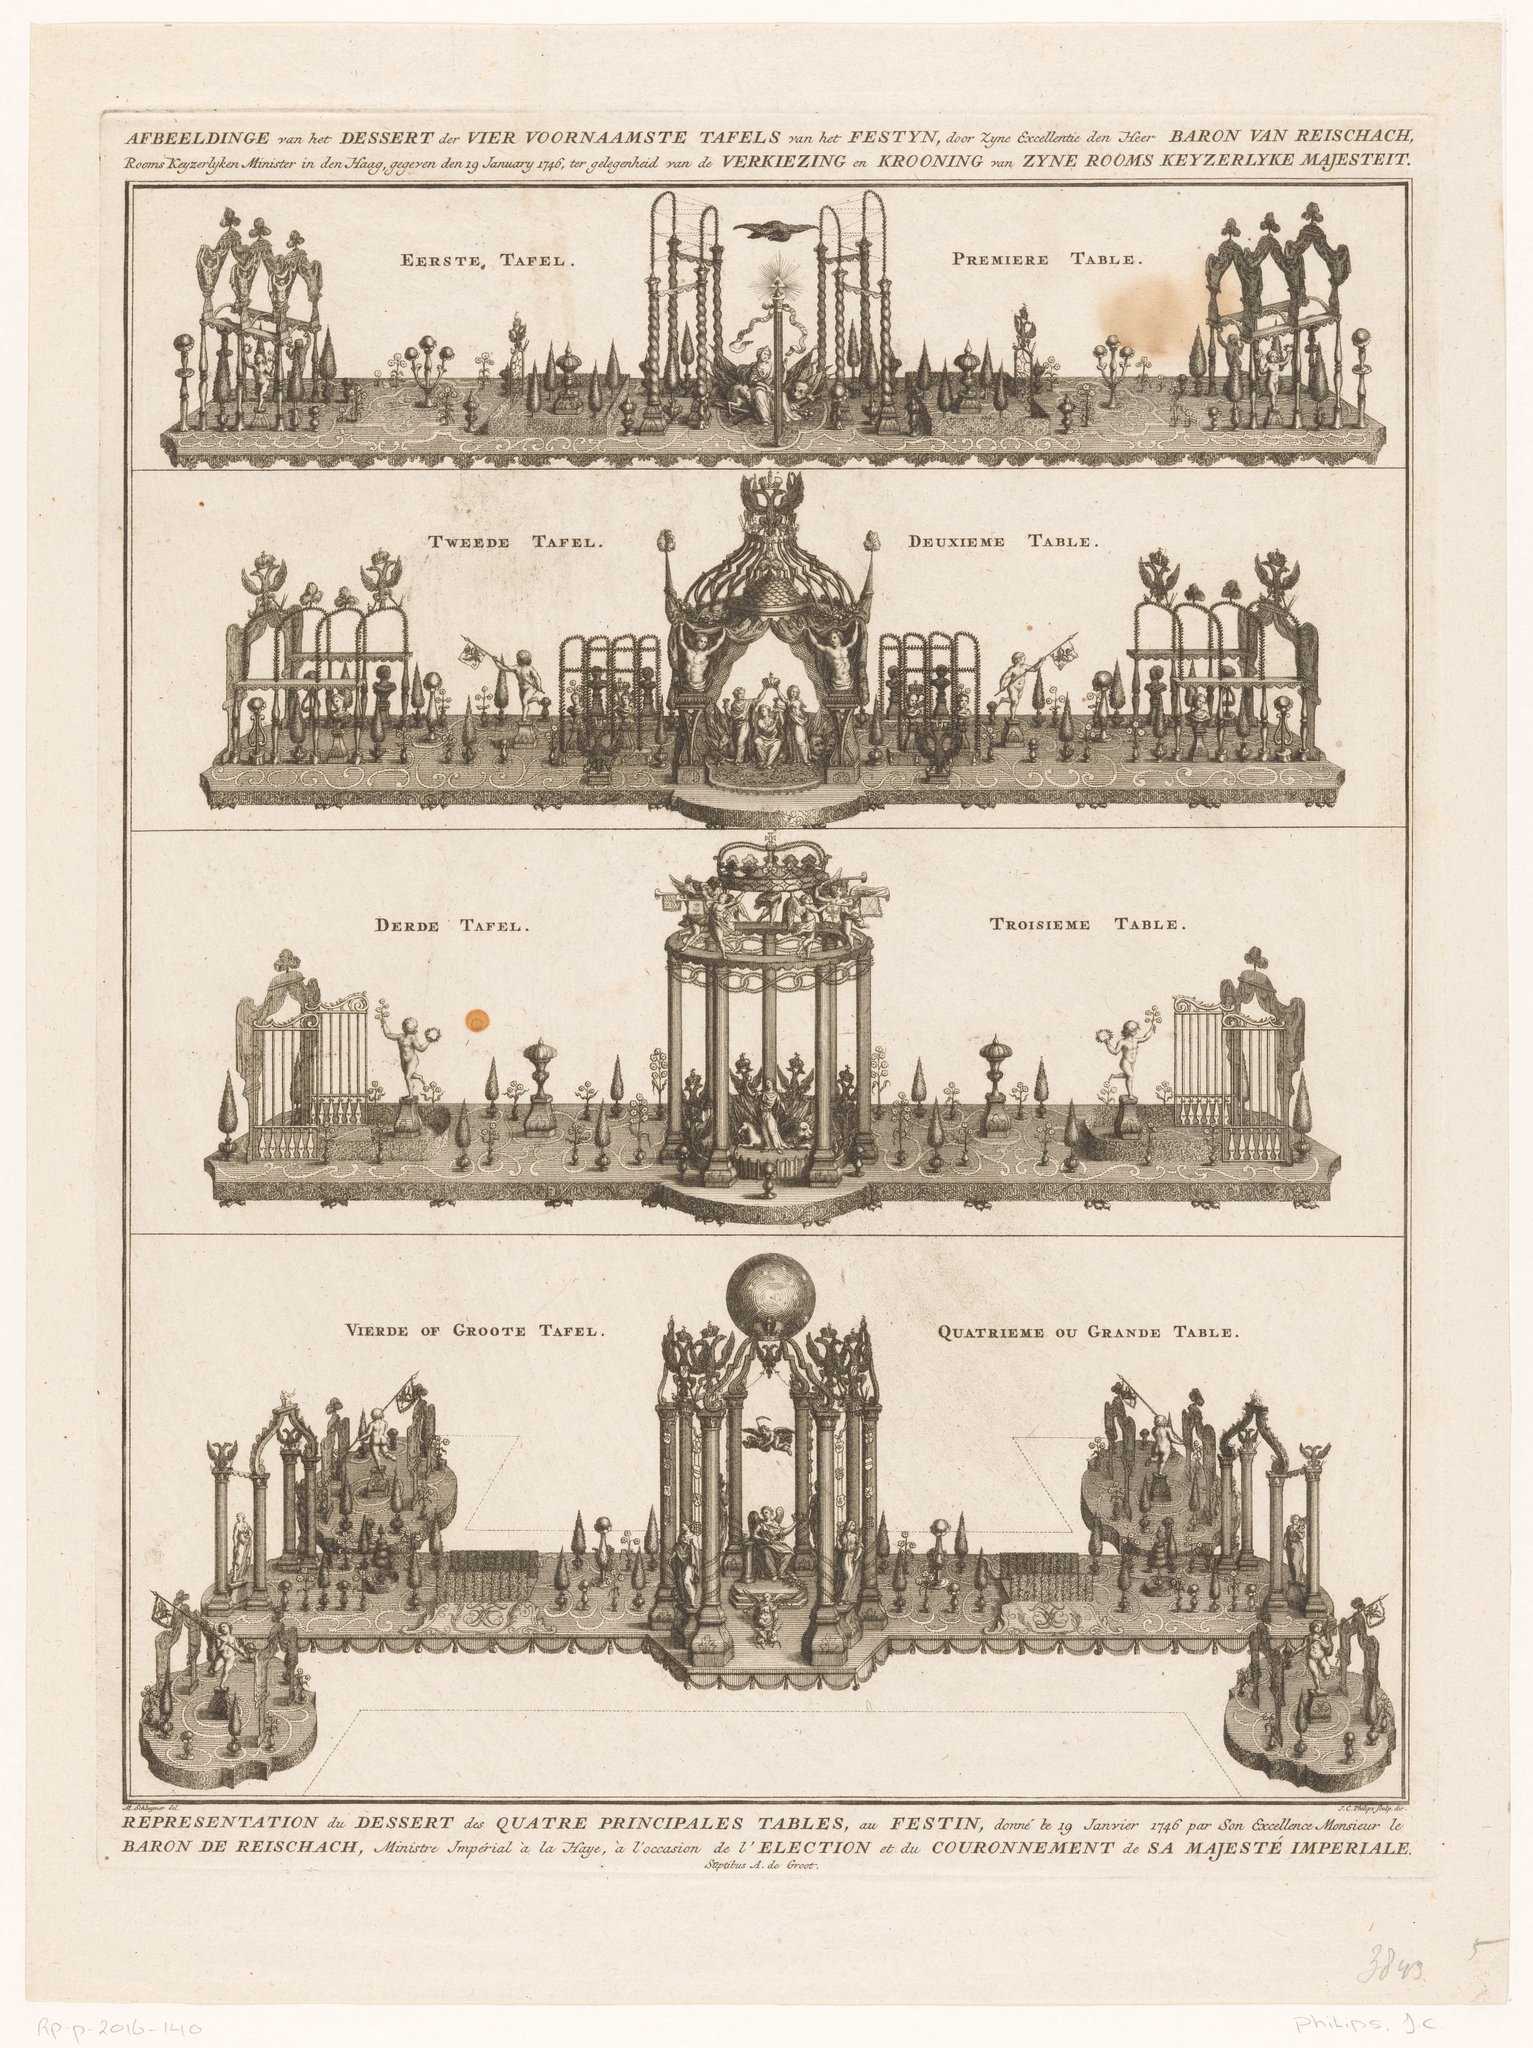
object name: print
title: Dessert op vier tafels bij het feestmaal ter ere van de kroning van keizer Frans I Stefan, 1746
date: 1746-1747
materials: paper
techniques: engraving, etching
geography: northern netherlands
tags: frans i stefan (duits keizer), public festivities (+ eating and drinking ~ festive activities), coronation of a ruler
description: Het dessert zoals het gepresenteerd is op de vier voornaamste tafels tijdens het feestmaal gegeven door de Duitse minister en afgezant baron van Reischach in het Mauritshuis op 19 januari 1746 ter gelegenheid van de kroning van Frans I Stefan tot keizer op 4-6 oktober 1745. Tafelstukken in de vorm van vier ornamentele tuinen met zuilen, prieëlen, tempels, allegorische figuren en engelen.